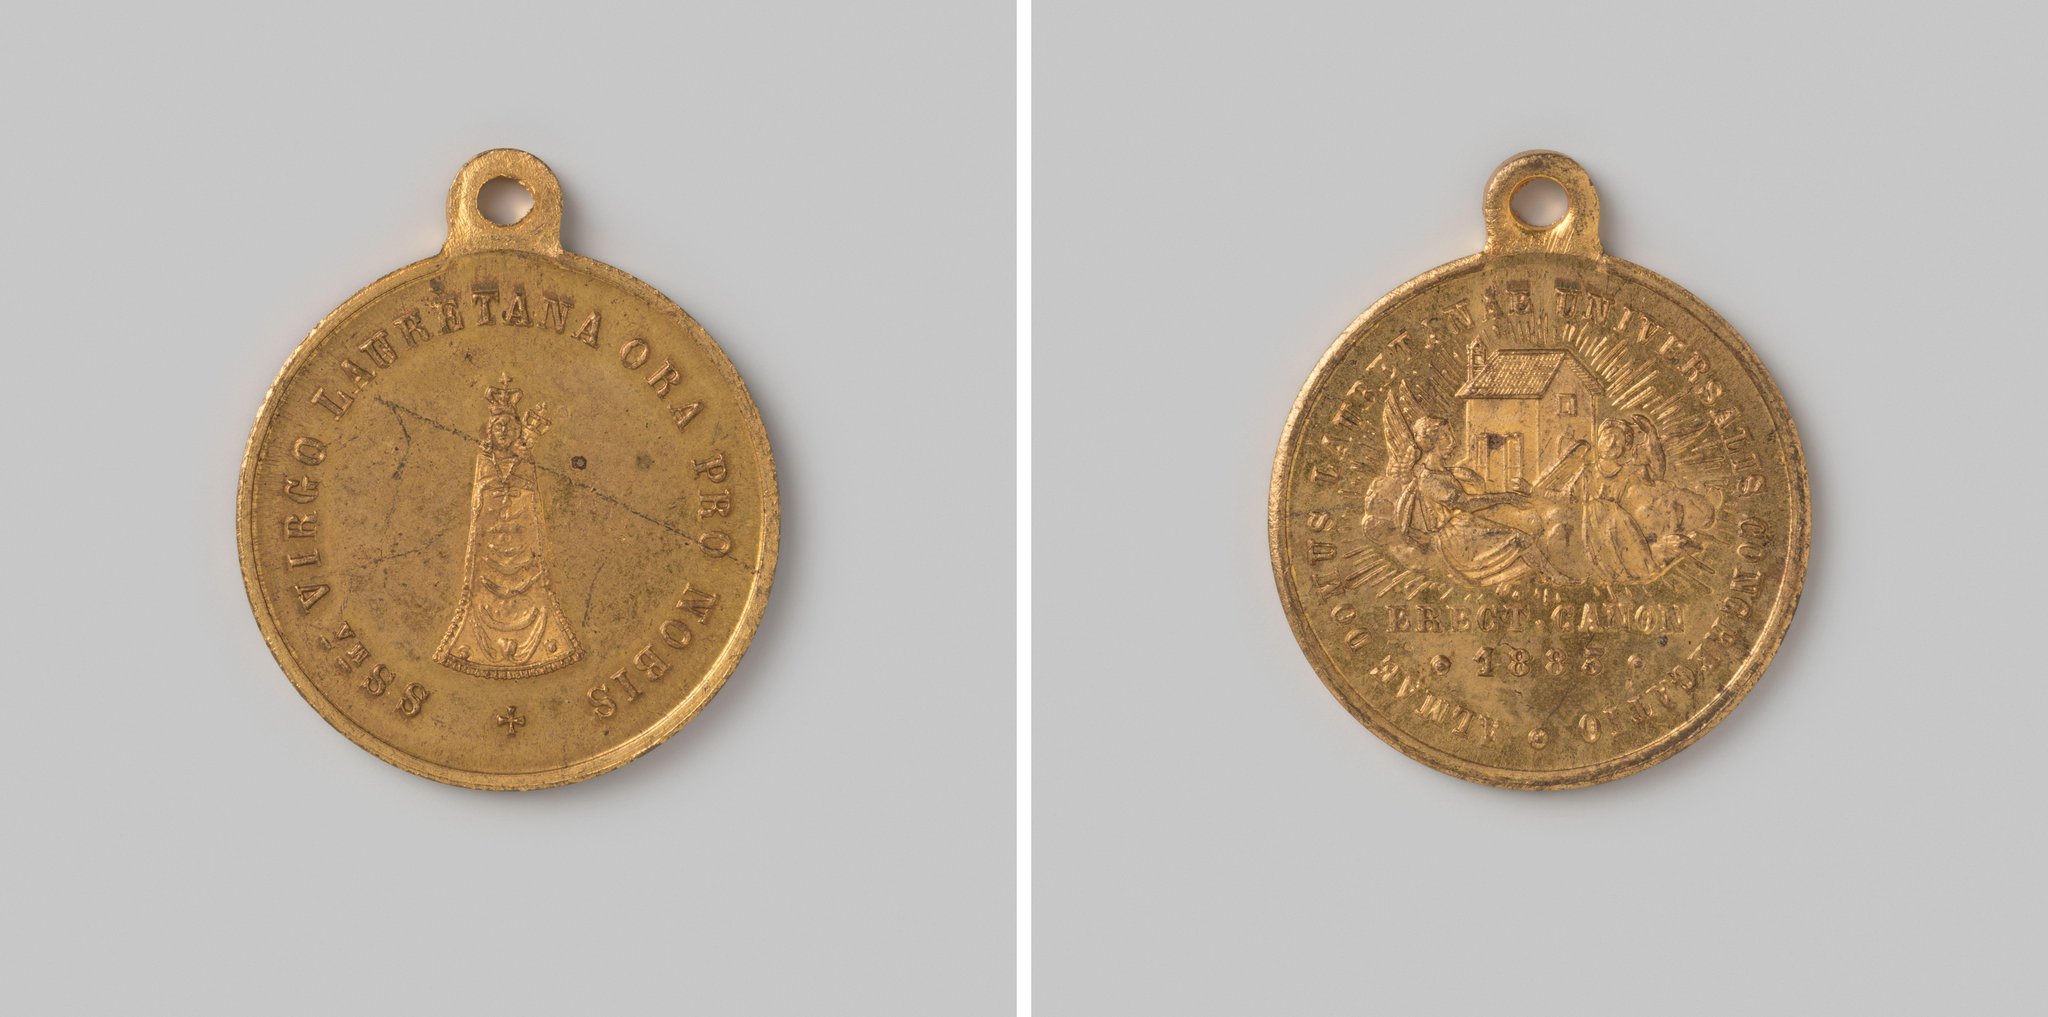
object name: history medal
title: Religieus draagteken met Maria van Loreto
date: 1883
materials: brass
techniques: striking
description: Vergulde penning met draagoog, op de voorzijde Maria van Loreto met omschrift, op de keerzijde twee engelen voor het Heilige Huis van Loreto, met afsnedetekst en omschrift.